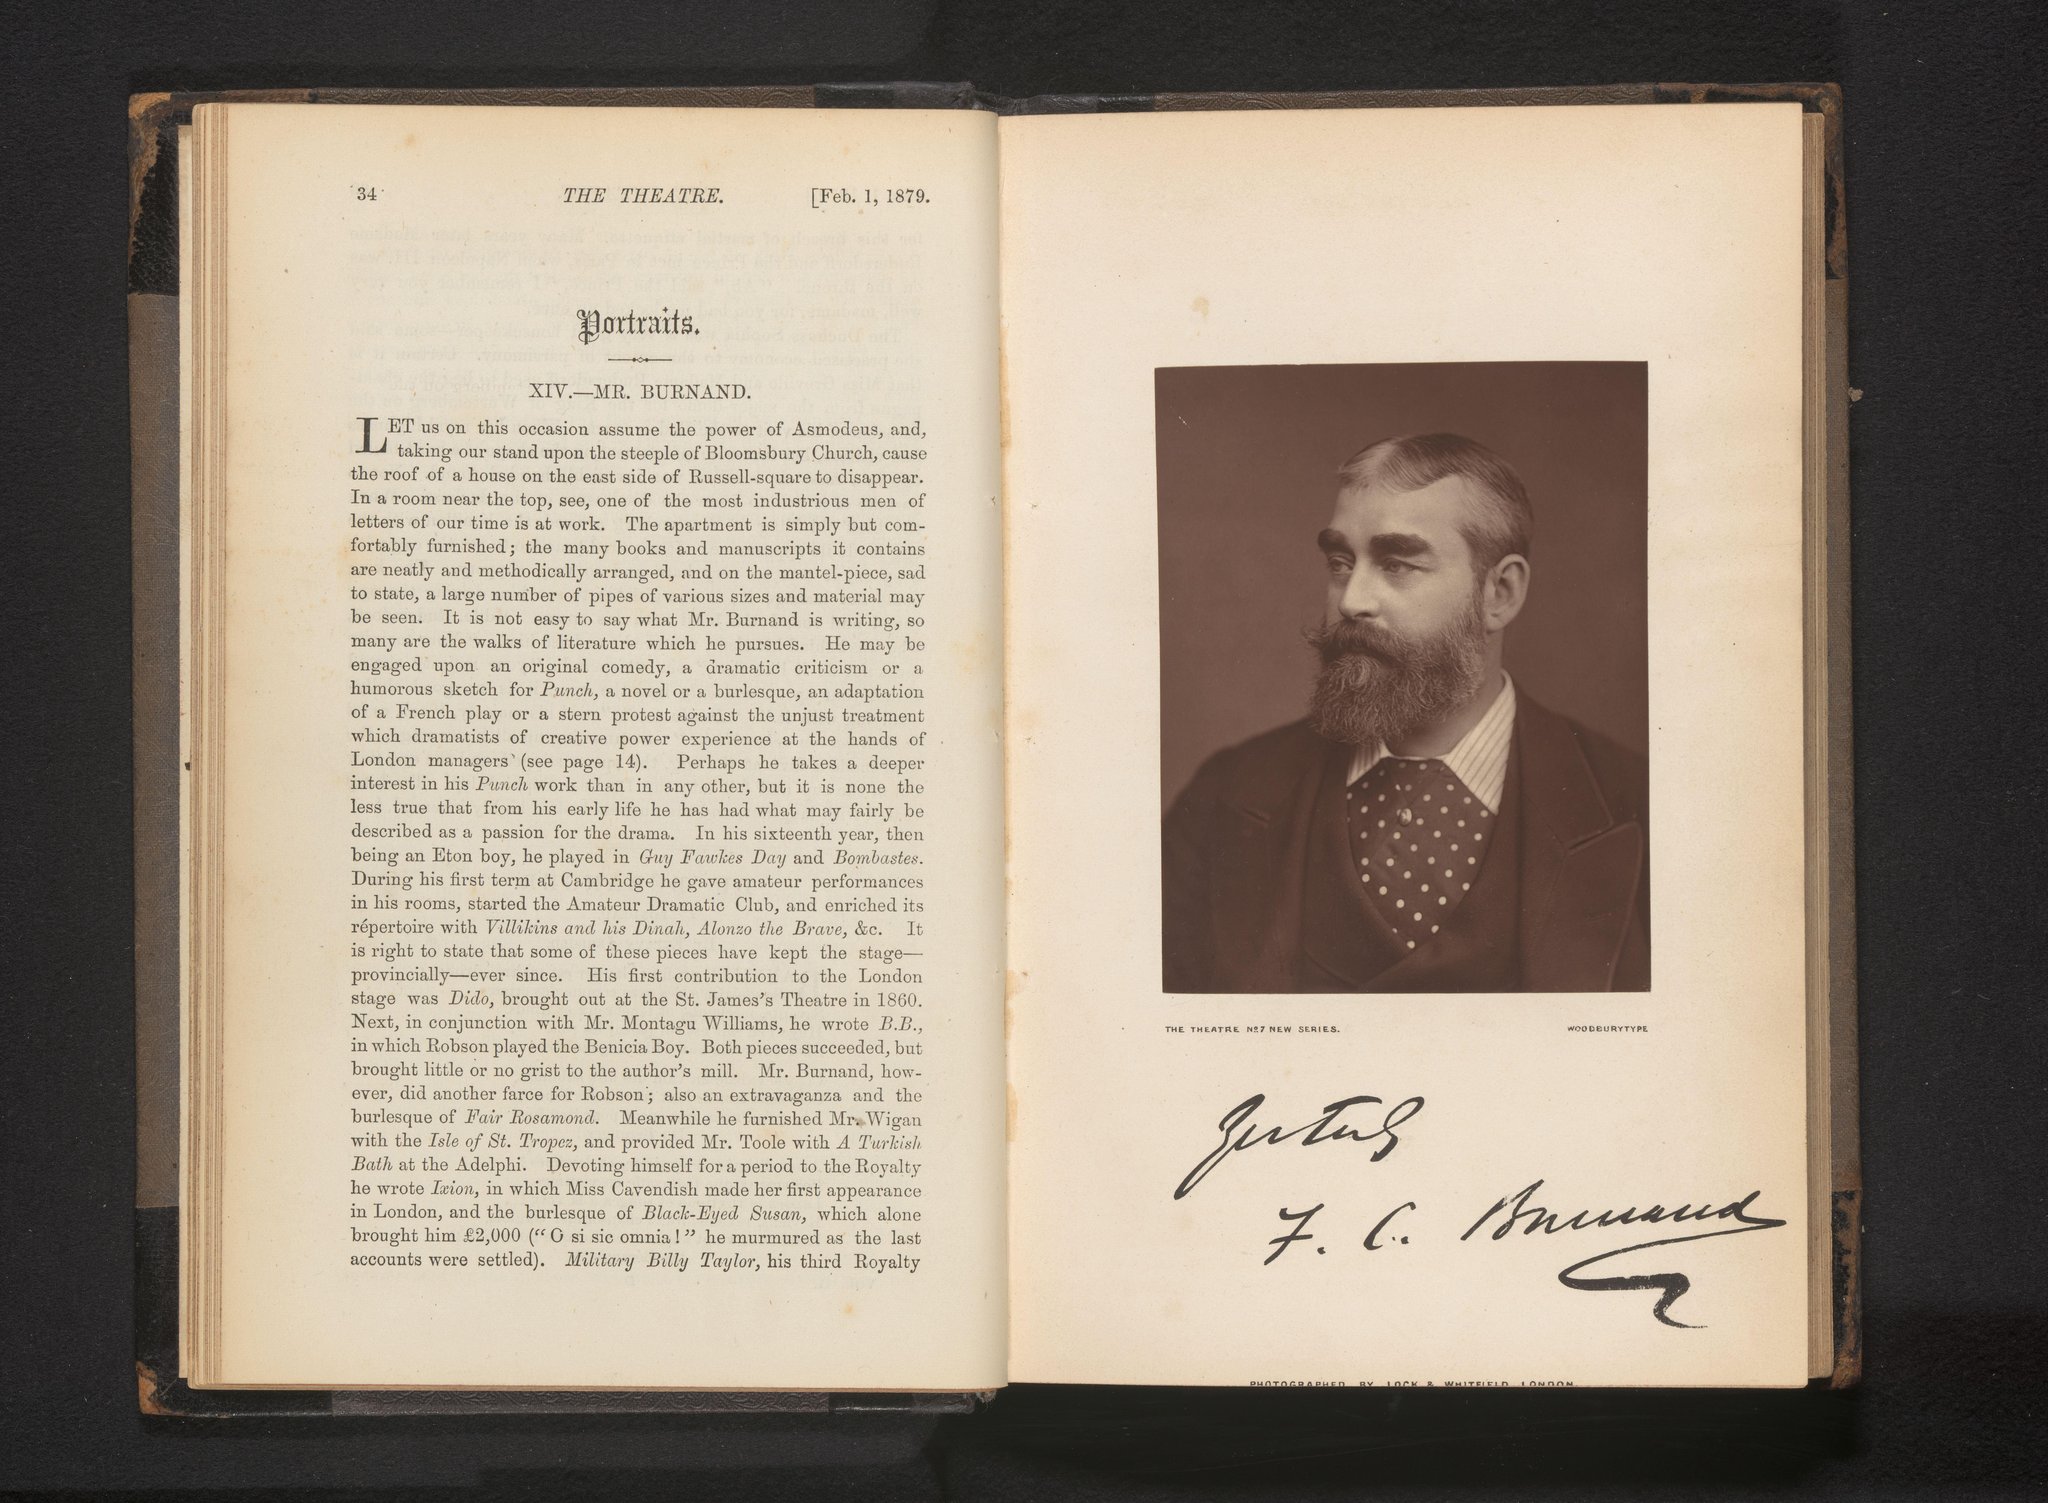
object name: photomechanical print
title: Portret van Mr. Burnand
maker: Anonymous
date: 1874-1879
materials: paper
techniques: woodburytype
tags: adult man, historical persons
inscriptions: signature: ‘[...]/ F.C. Burnand’